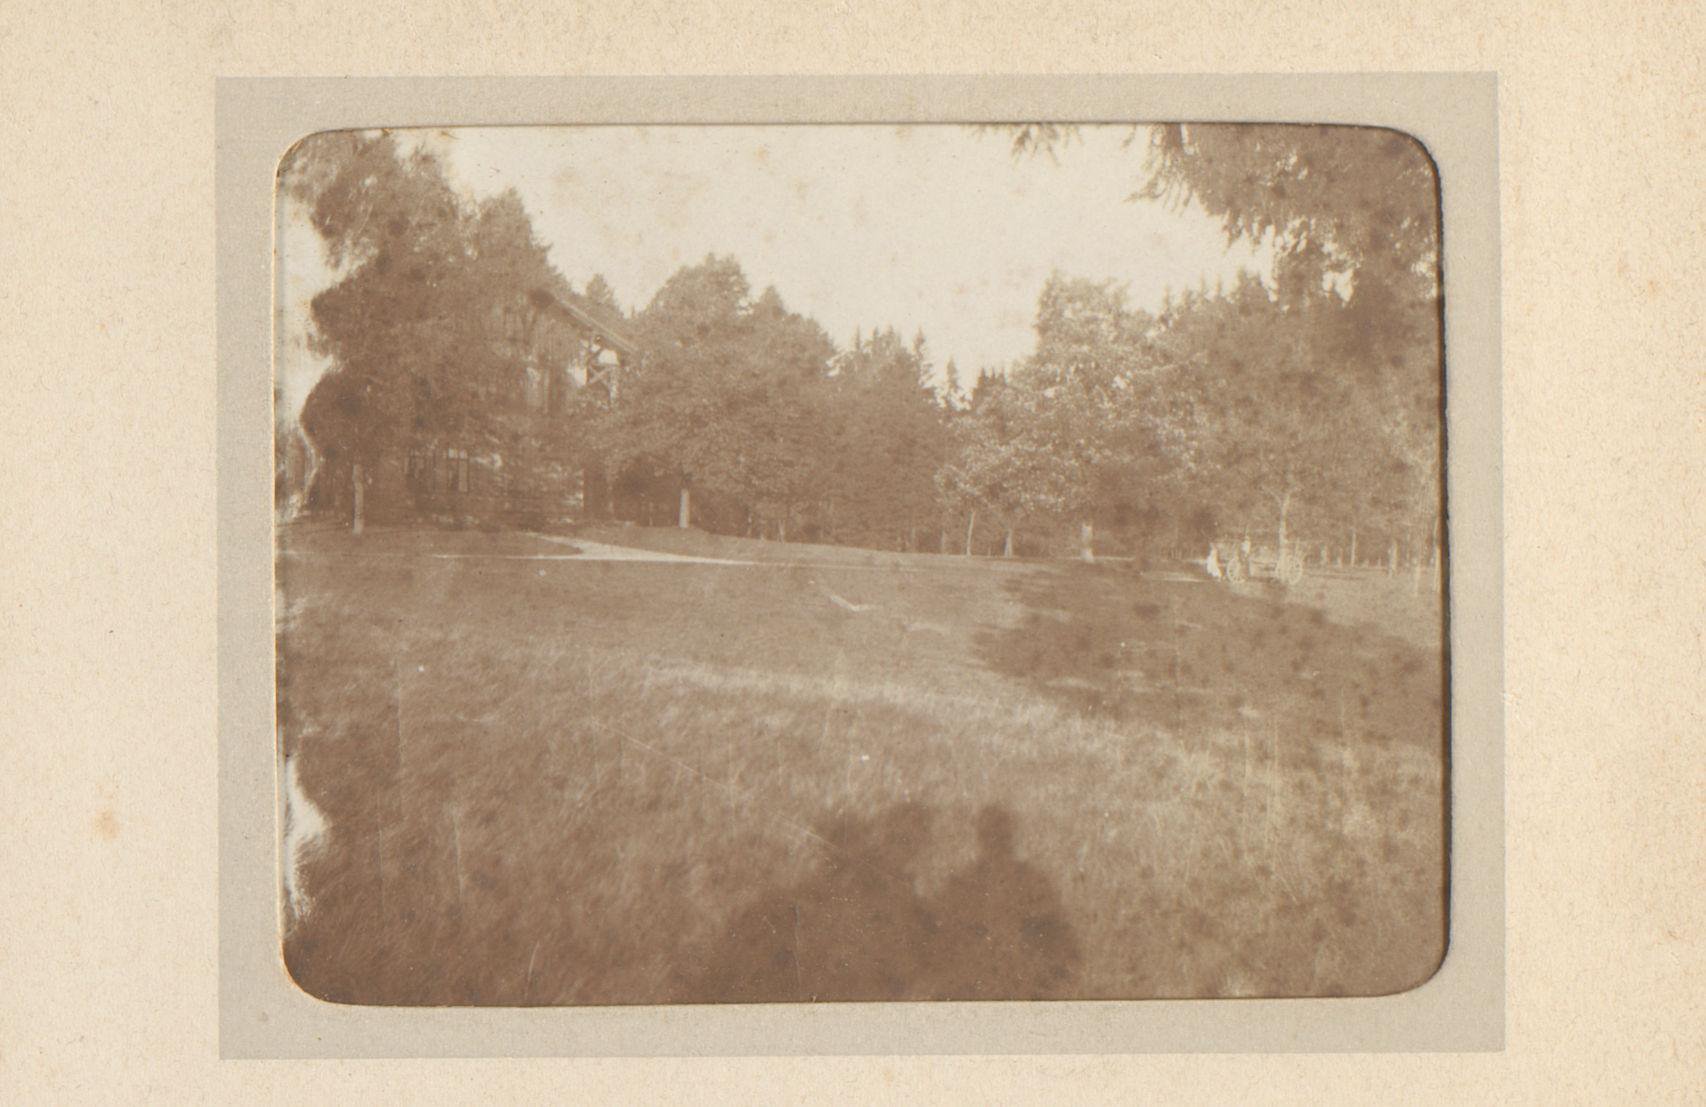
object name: album leaf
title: Gezicht op een grasveld in het bos met op de achtergrond een huis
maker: liesbeth overhoff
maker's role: fotograaf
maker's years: 1895-1969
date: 1910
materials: paper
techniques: matte daylight collodion silver print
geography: friedrichroda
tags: meadow, pasture, fringe, edge of the wood, farm or solitary house in landscape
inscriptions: inscription: ‘- 1910 -/ Friedrichroda.’